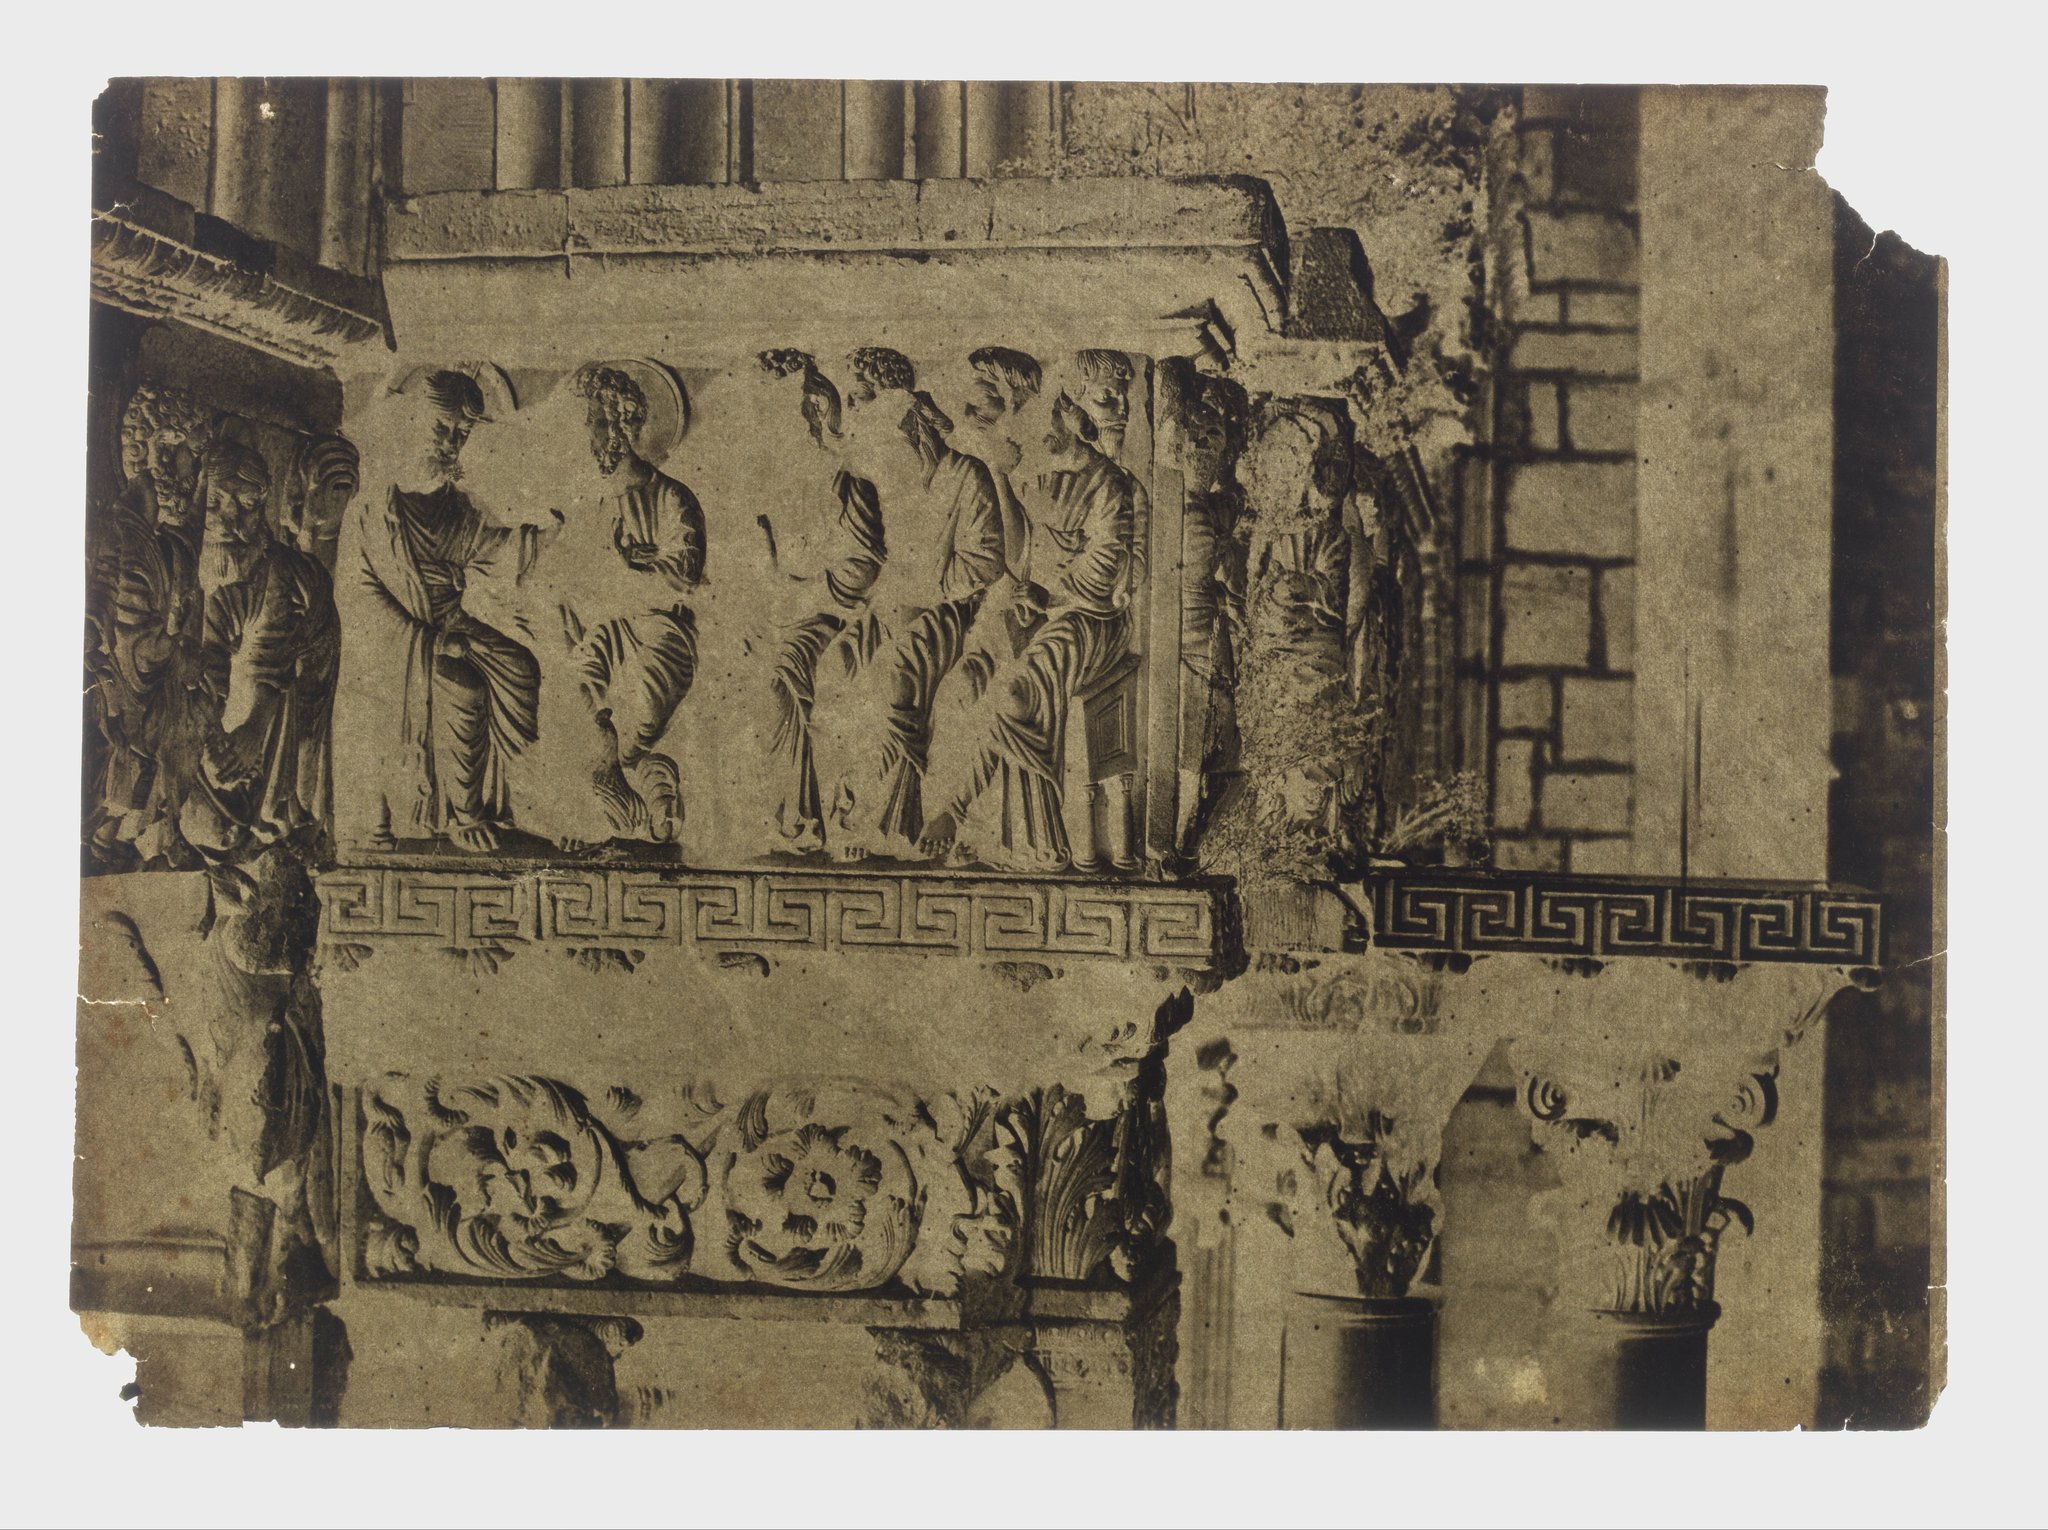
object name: papiernegatief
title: Bas-reliëf aan de kerk van Saint-Gilles-du-Gard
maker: charles nègre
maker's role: fotograaf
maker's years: 1820-1880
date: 1852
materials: paper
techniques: paper negative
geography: saint-gilles-du-gard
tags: sculpture